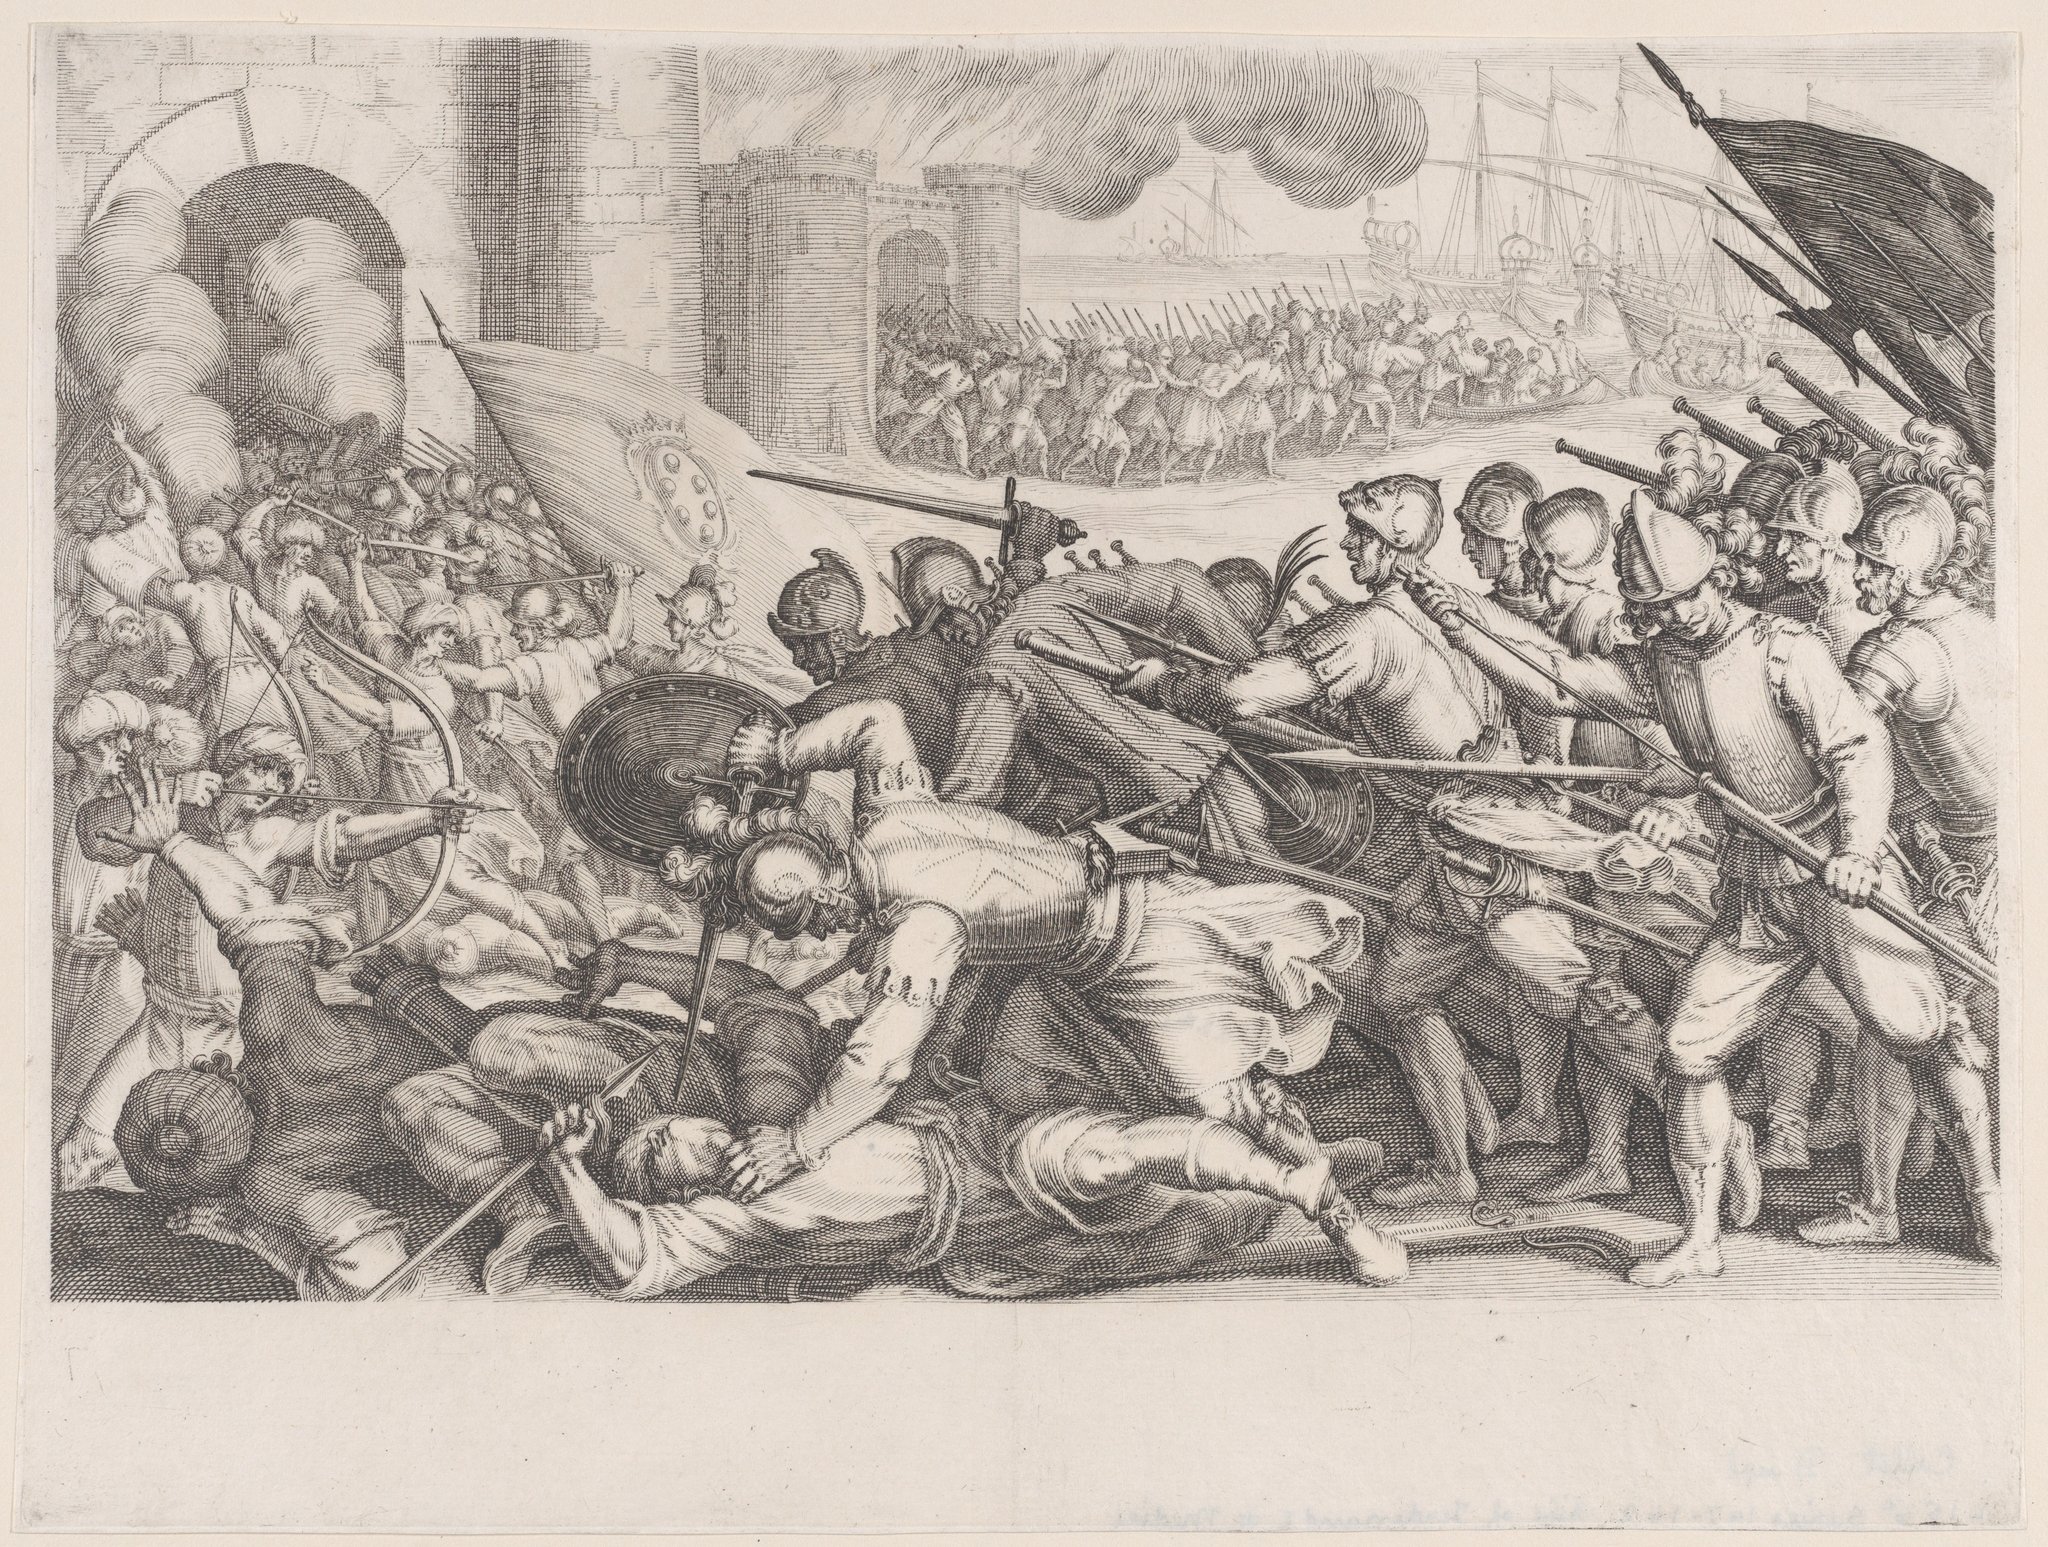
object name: print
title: Les Troupes Forcent la Porte d'une Ville (The Troops Force Their Way Through the Gate of a City), from La Vie de Ferdinand Ier de Médicis série appelée aussi Les Batailles des Médicis (The Life of Ferdinand I de'Medici also called The Medici Battles)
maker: jacques callot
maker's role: artist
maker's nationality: french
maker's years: 1592-1635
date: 1614-1620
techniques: engraving